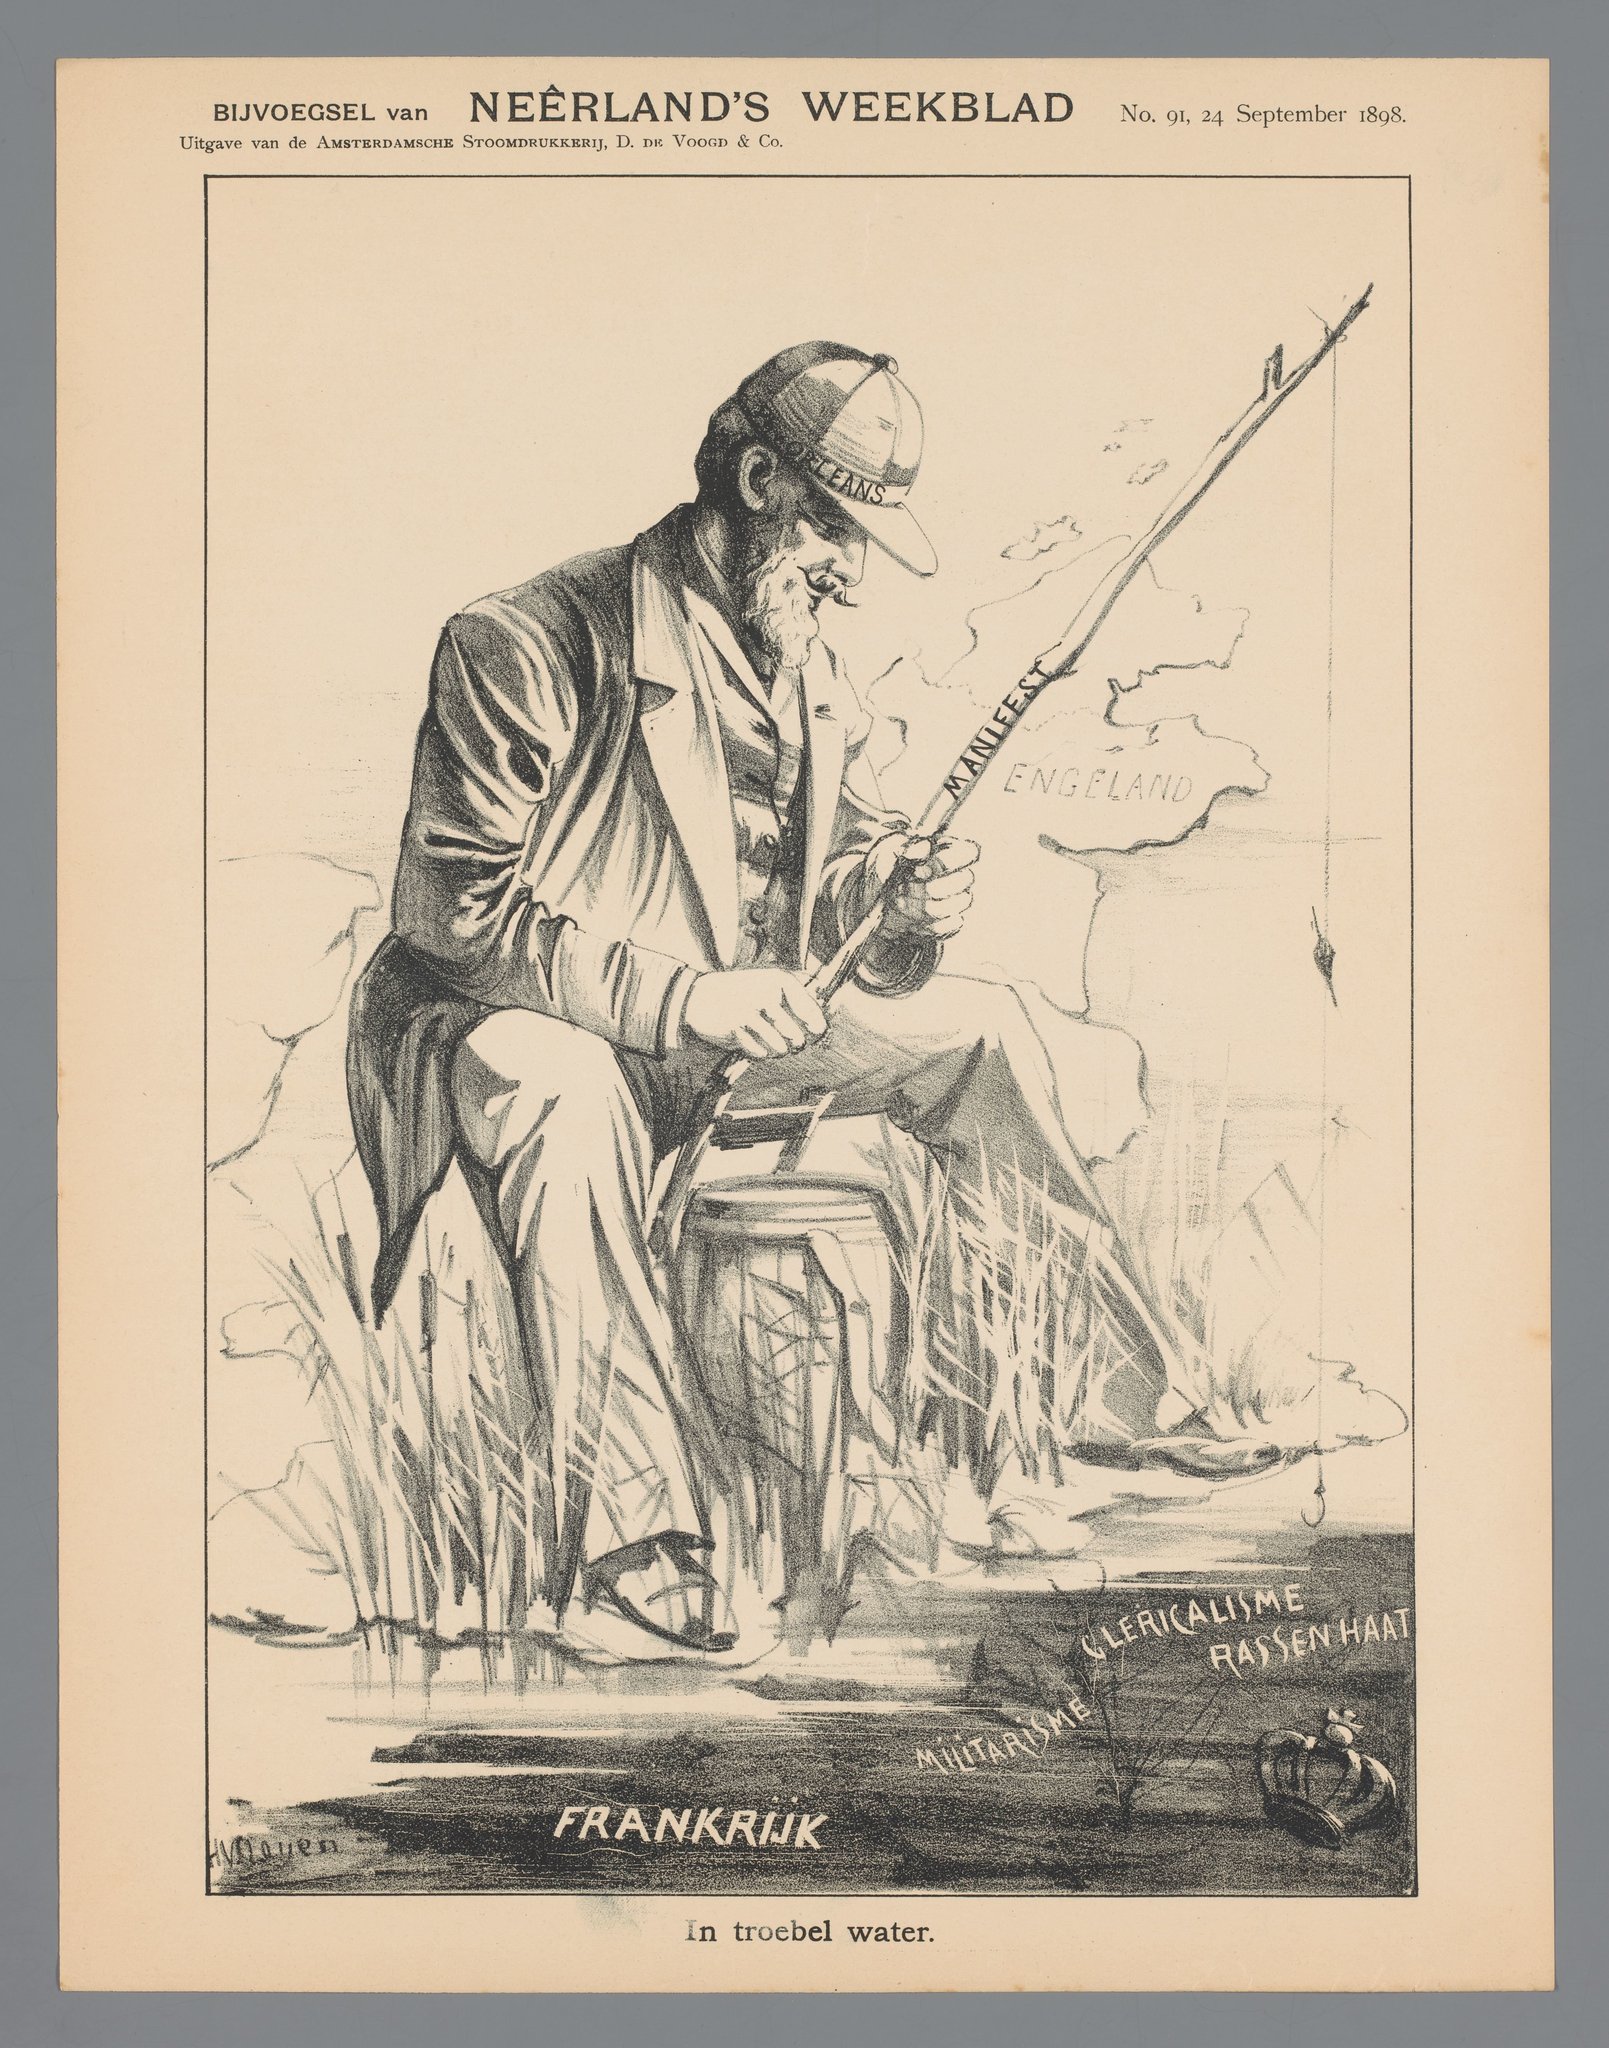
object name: cartoon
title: In troebel water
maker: h. van ooijen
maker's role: print maker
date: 1898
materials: paper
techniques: lithograph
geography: amsterdam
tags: fisherman, political caricatures and satires, france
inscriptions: date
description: Prent uit het bijvoegsel van: Neêrland’s Weekblad, nr. 91, 24 september 1898.